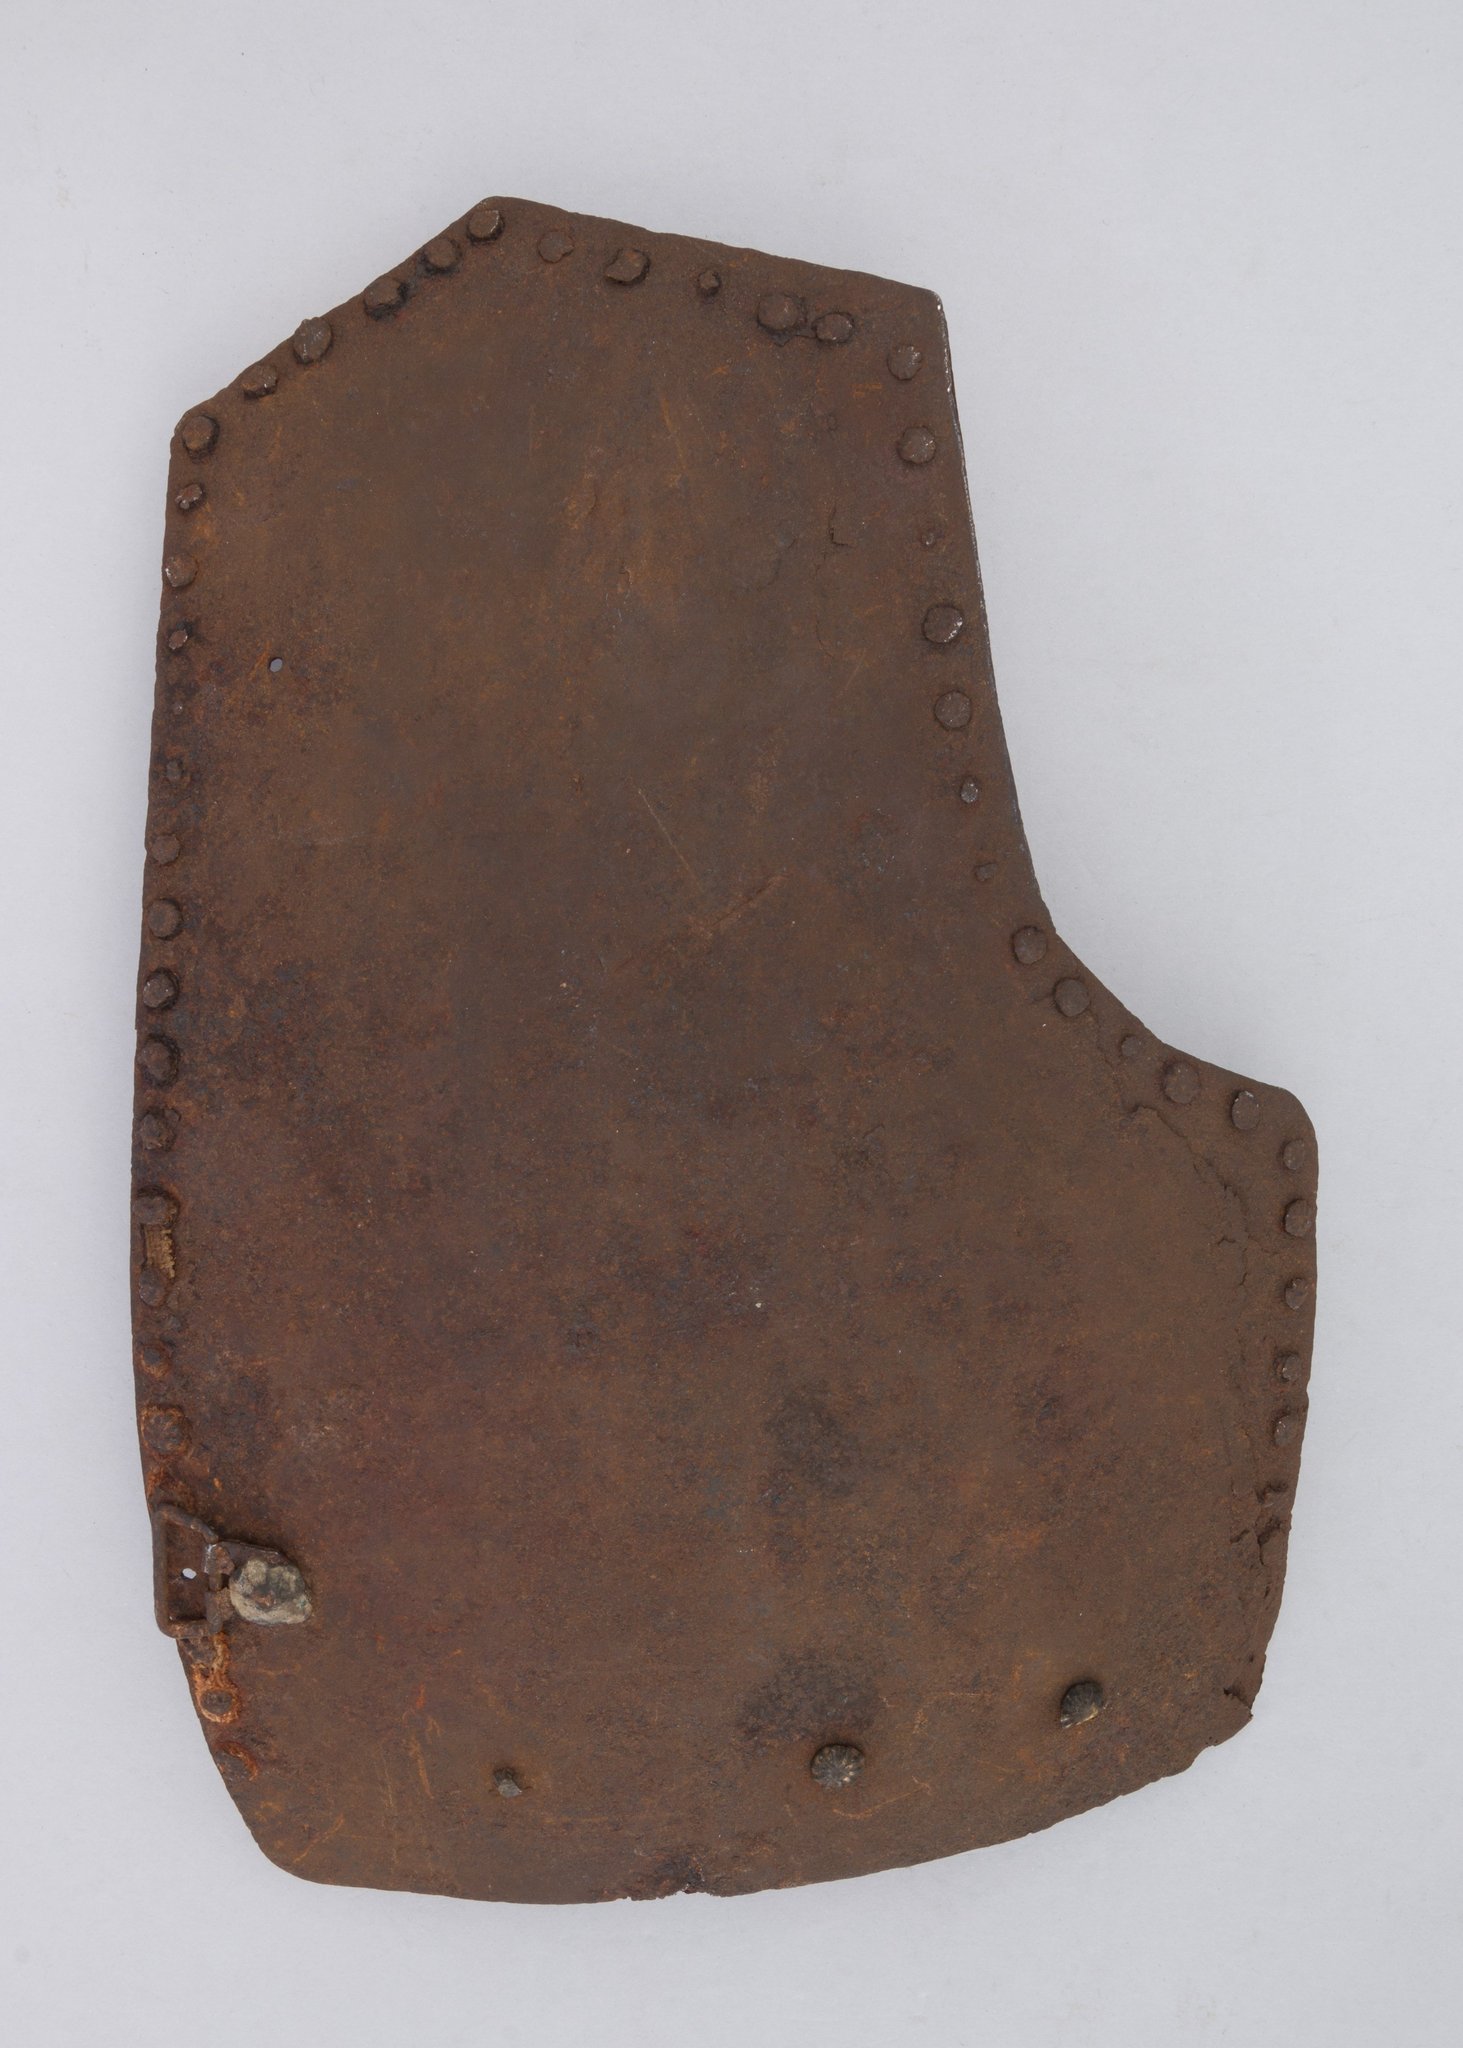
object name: brigandine plate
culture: italian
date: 1400-1450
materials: copper alloy, metal alloy, textile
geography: italy